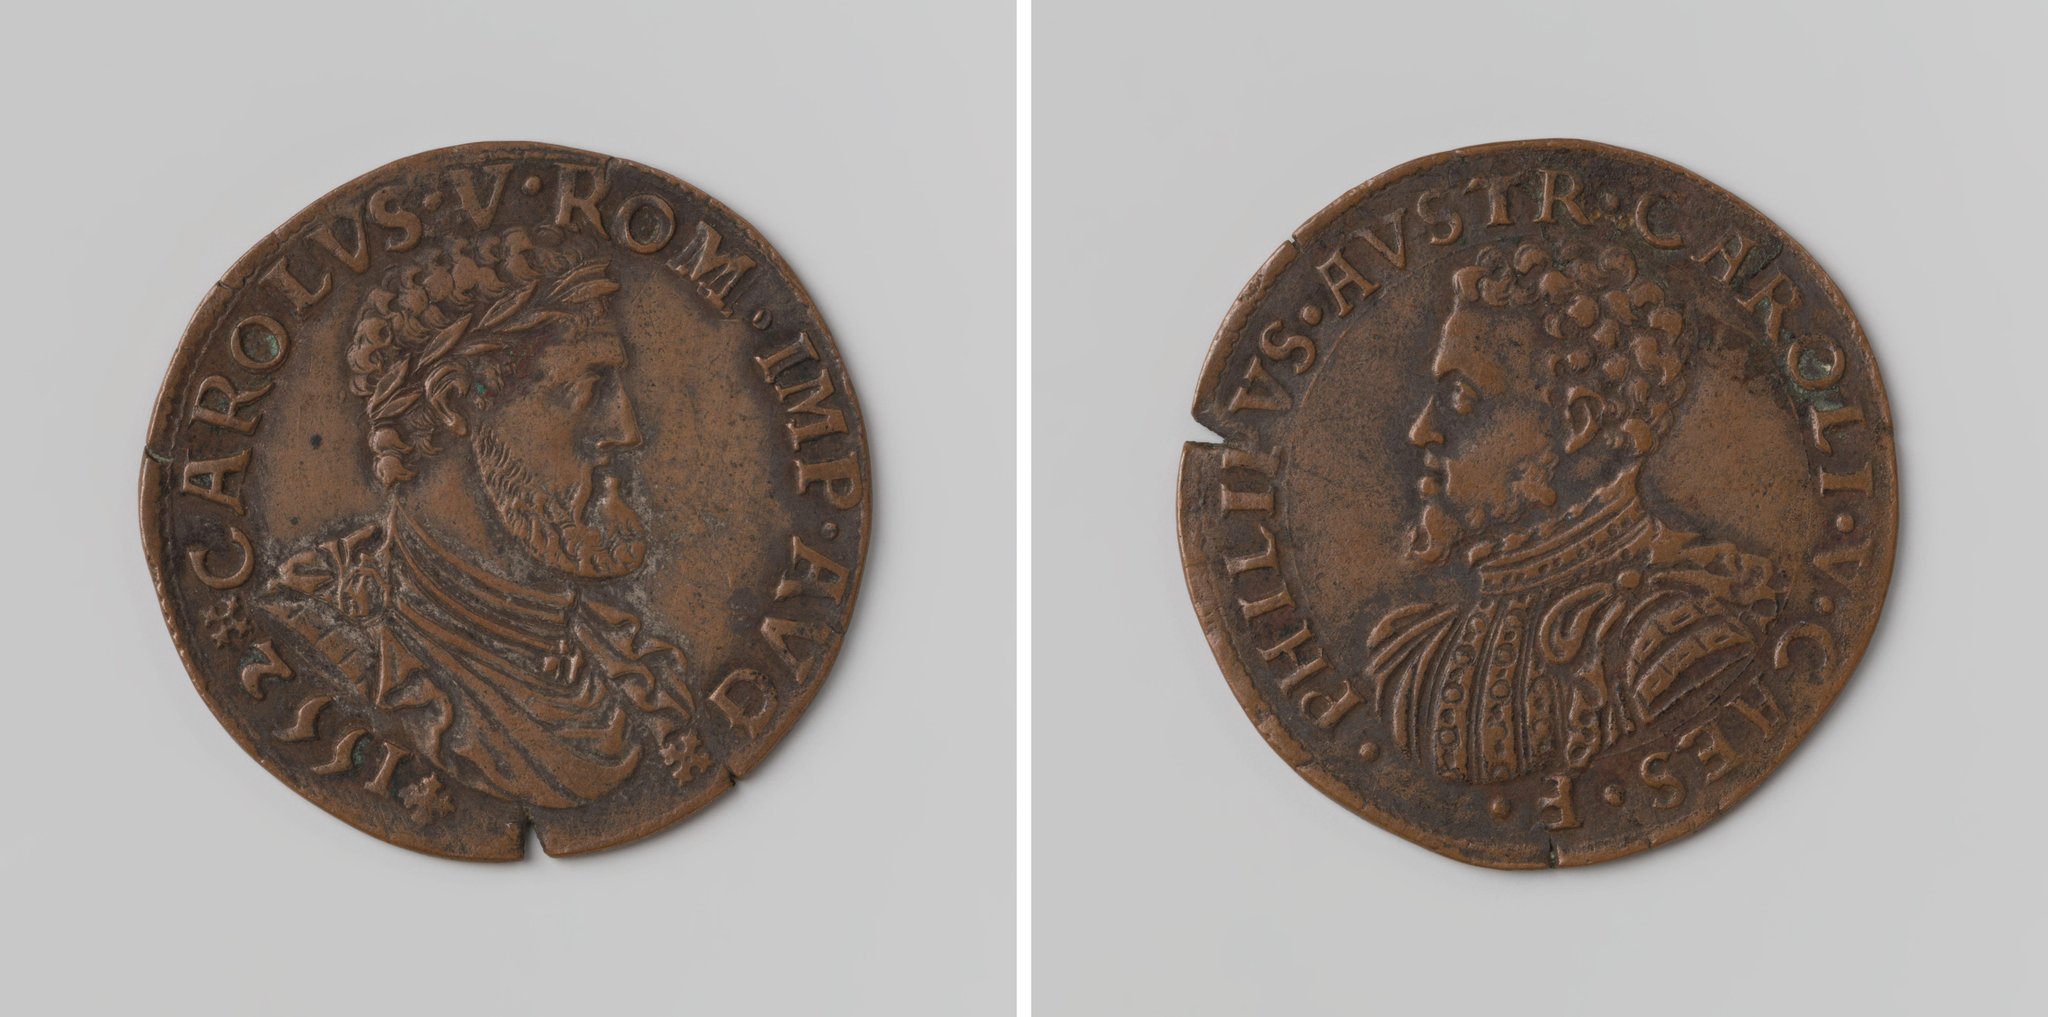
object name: jeton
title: Karel V, Duits keizer en zijn zoon Filips, erfprins van Spanje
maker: Anonymous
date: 1552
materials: copper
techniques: striking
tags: philip ii of spain, ghent, charles v (holy roman emperor and king of spain)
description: Koperen penning. Voorzijde: borststuk man met lauwerkrans binnen omschrift. Keerzijde: borststuk man binnen omschrift